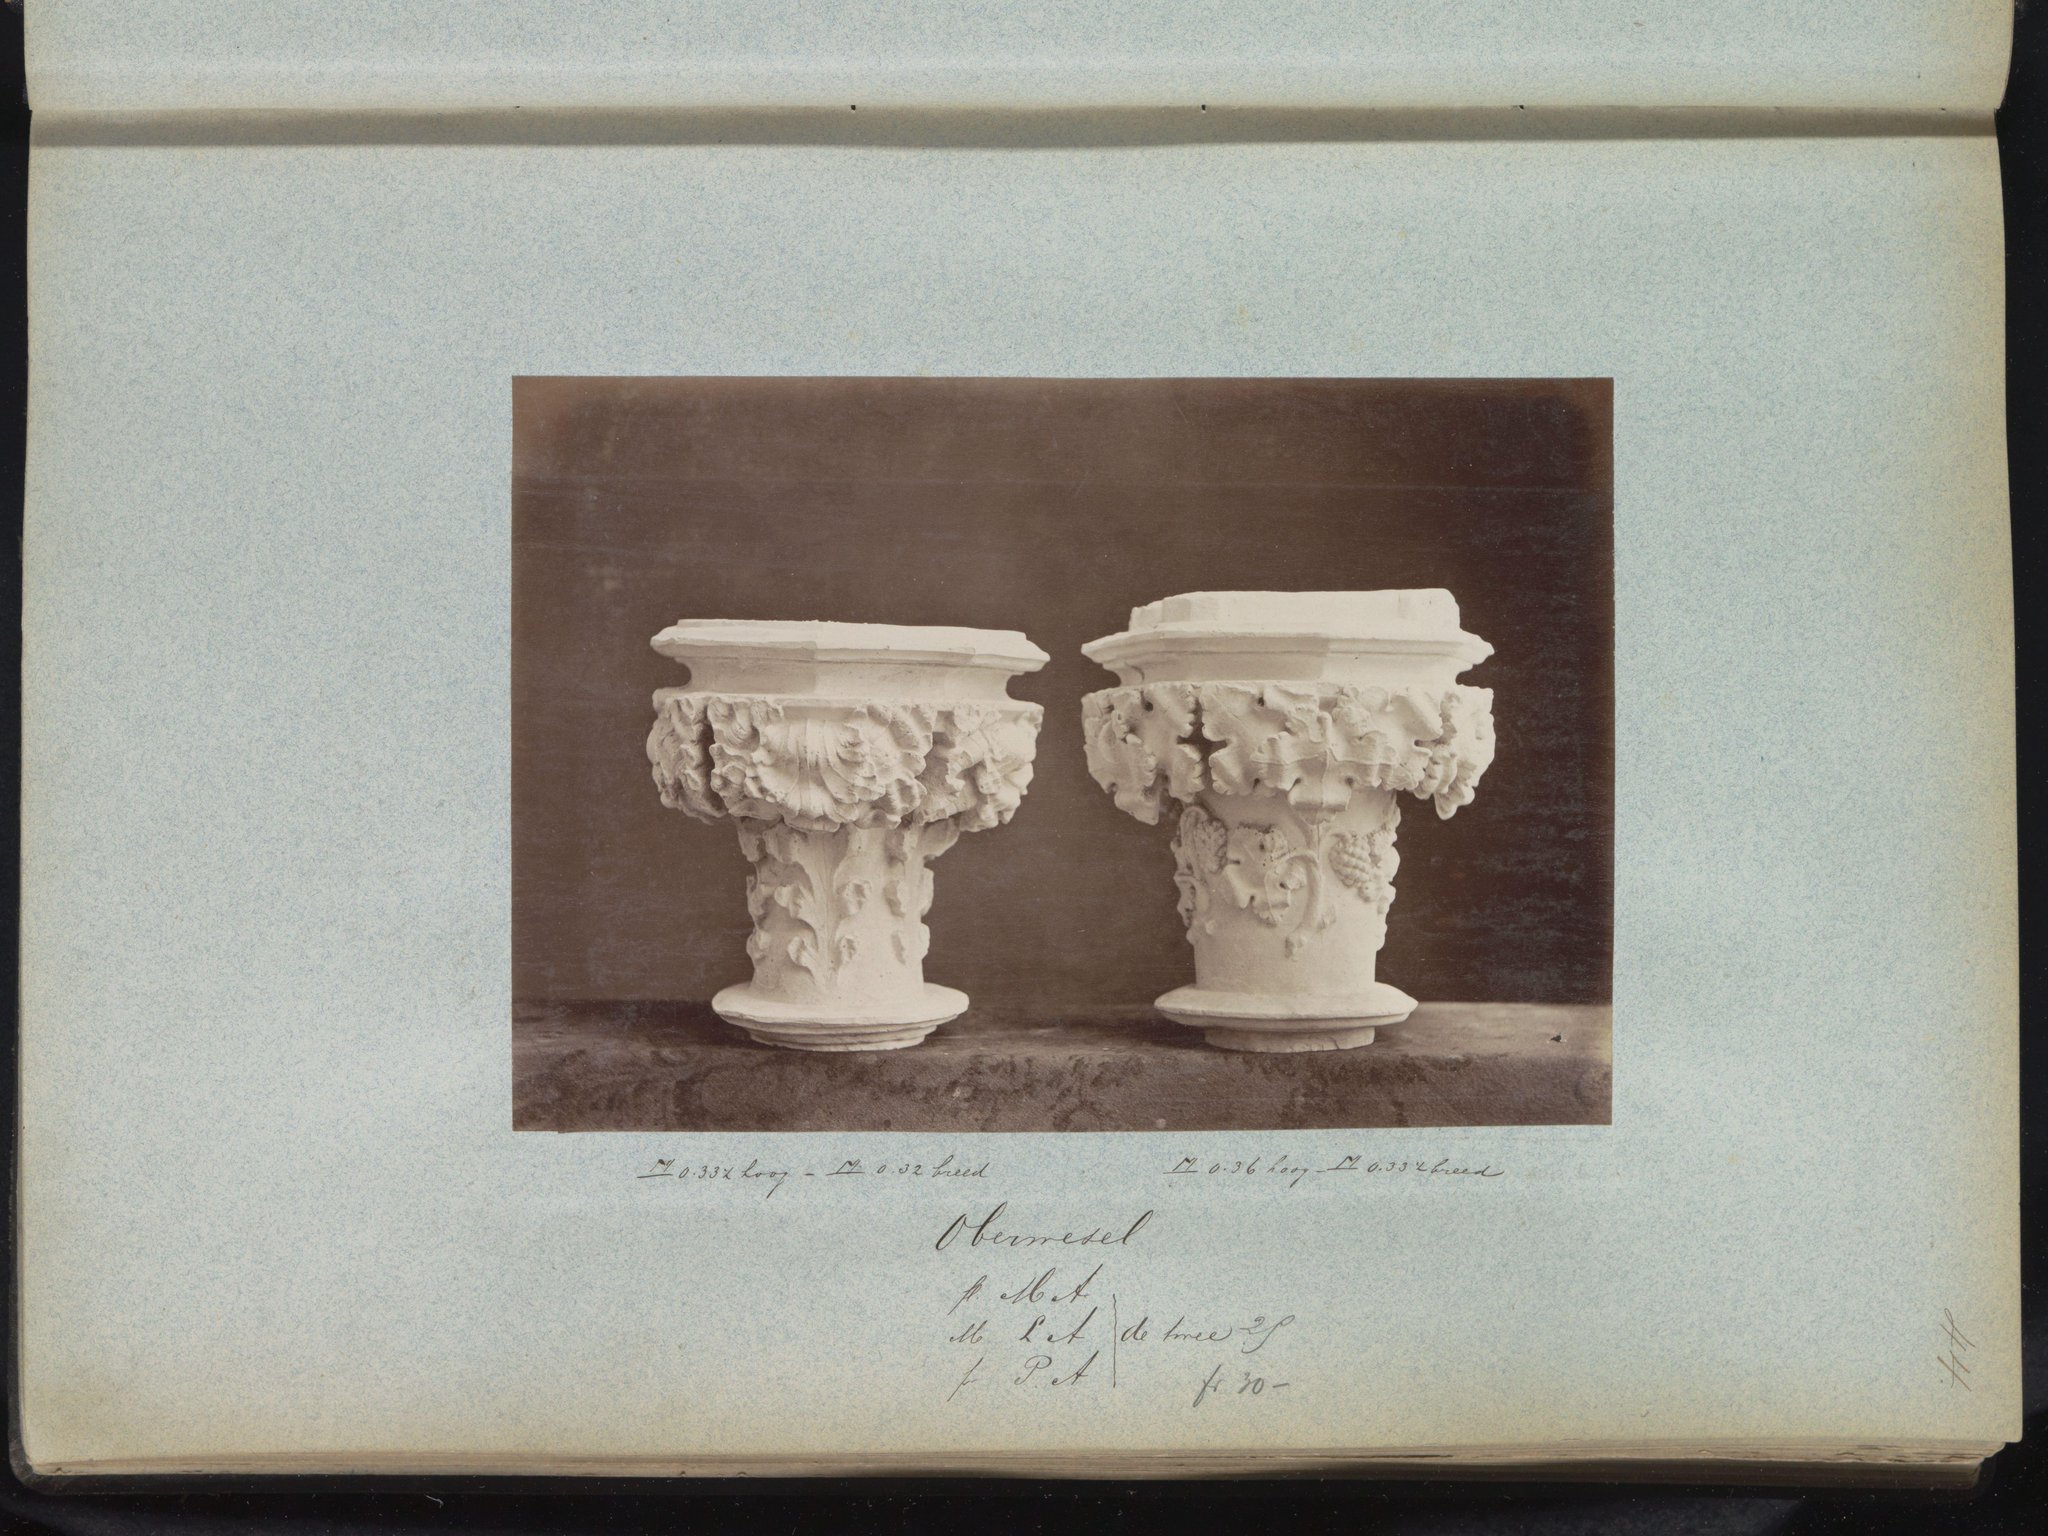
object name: album leaf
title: Twee gipsen afgietsels van kapitelen, vermoedelijk uit een kerk in Oberwesel, te Duitsland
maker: Anonymous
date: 1875-1900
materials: paper, photographic support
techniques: albumen print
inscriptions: annotation, annotation: ‘Oberwesel’, annotation: ‘M 0.33 1/2 hoog M 0.32 breed M 0.36 hoog M 0.33 breed’